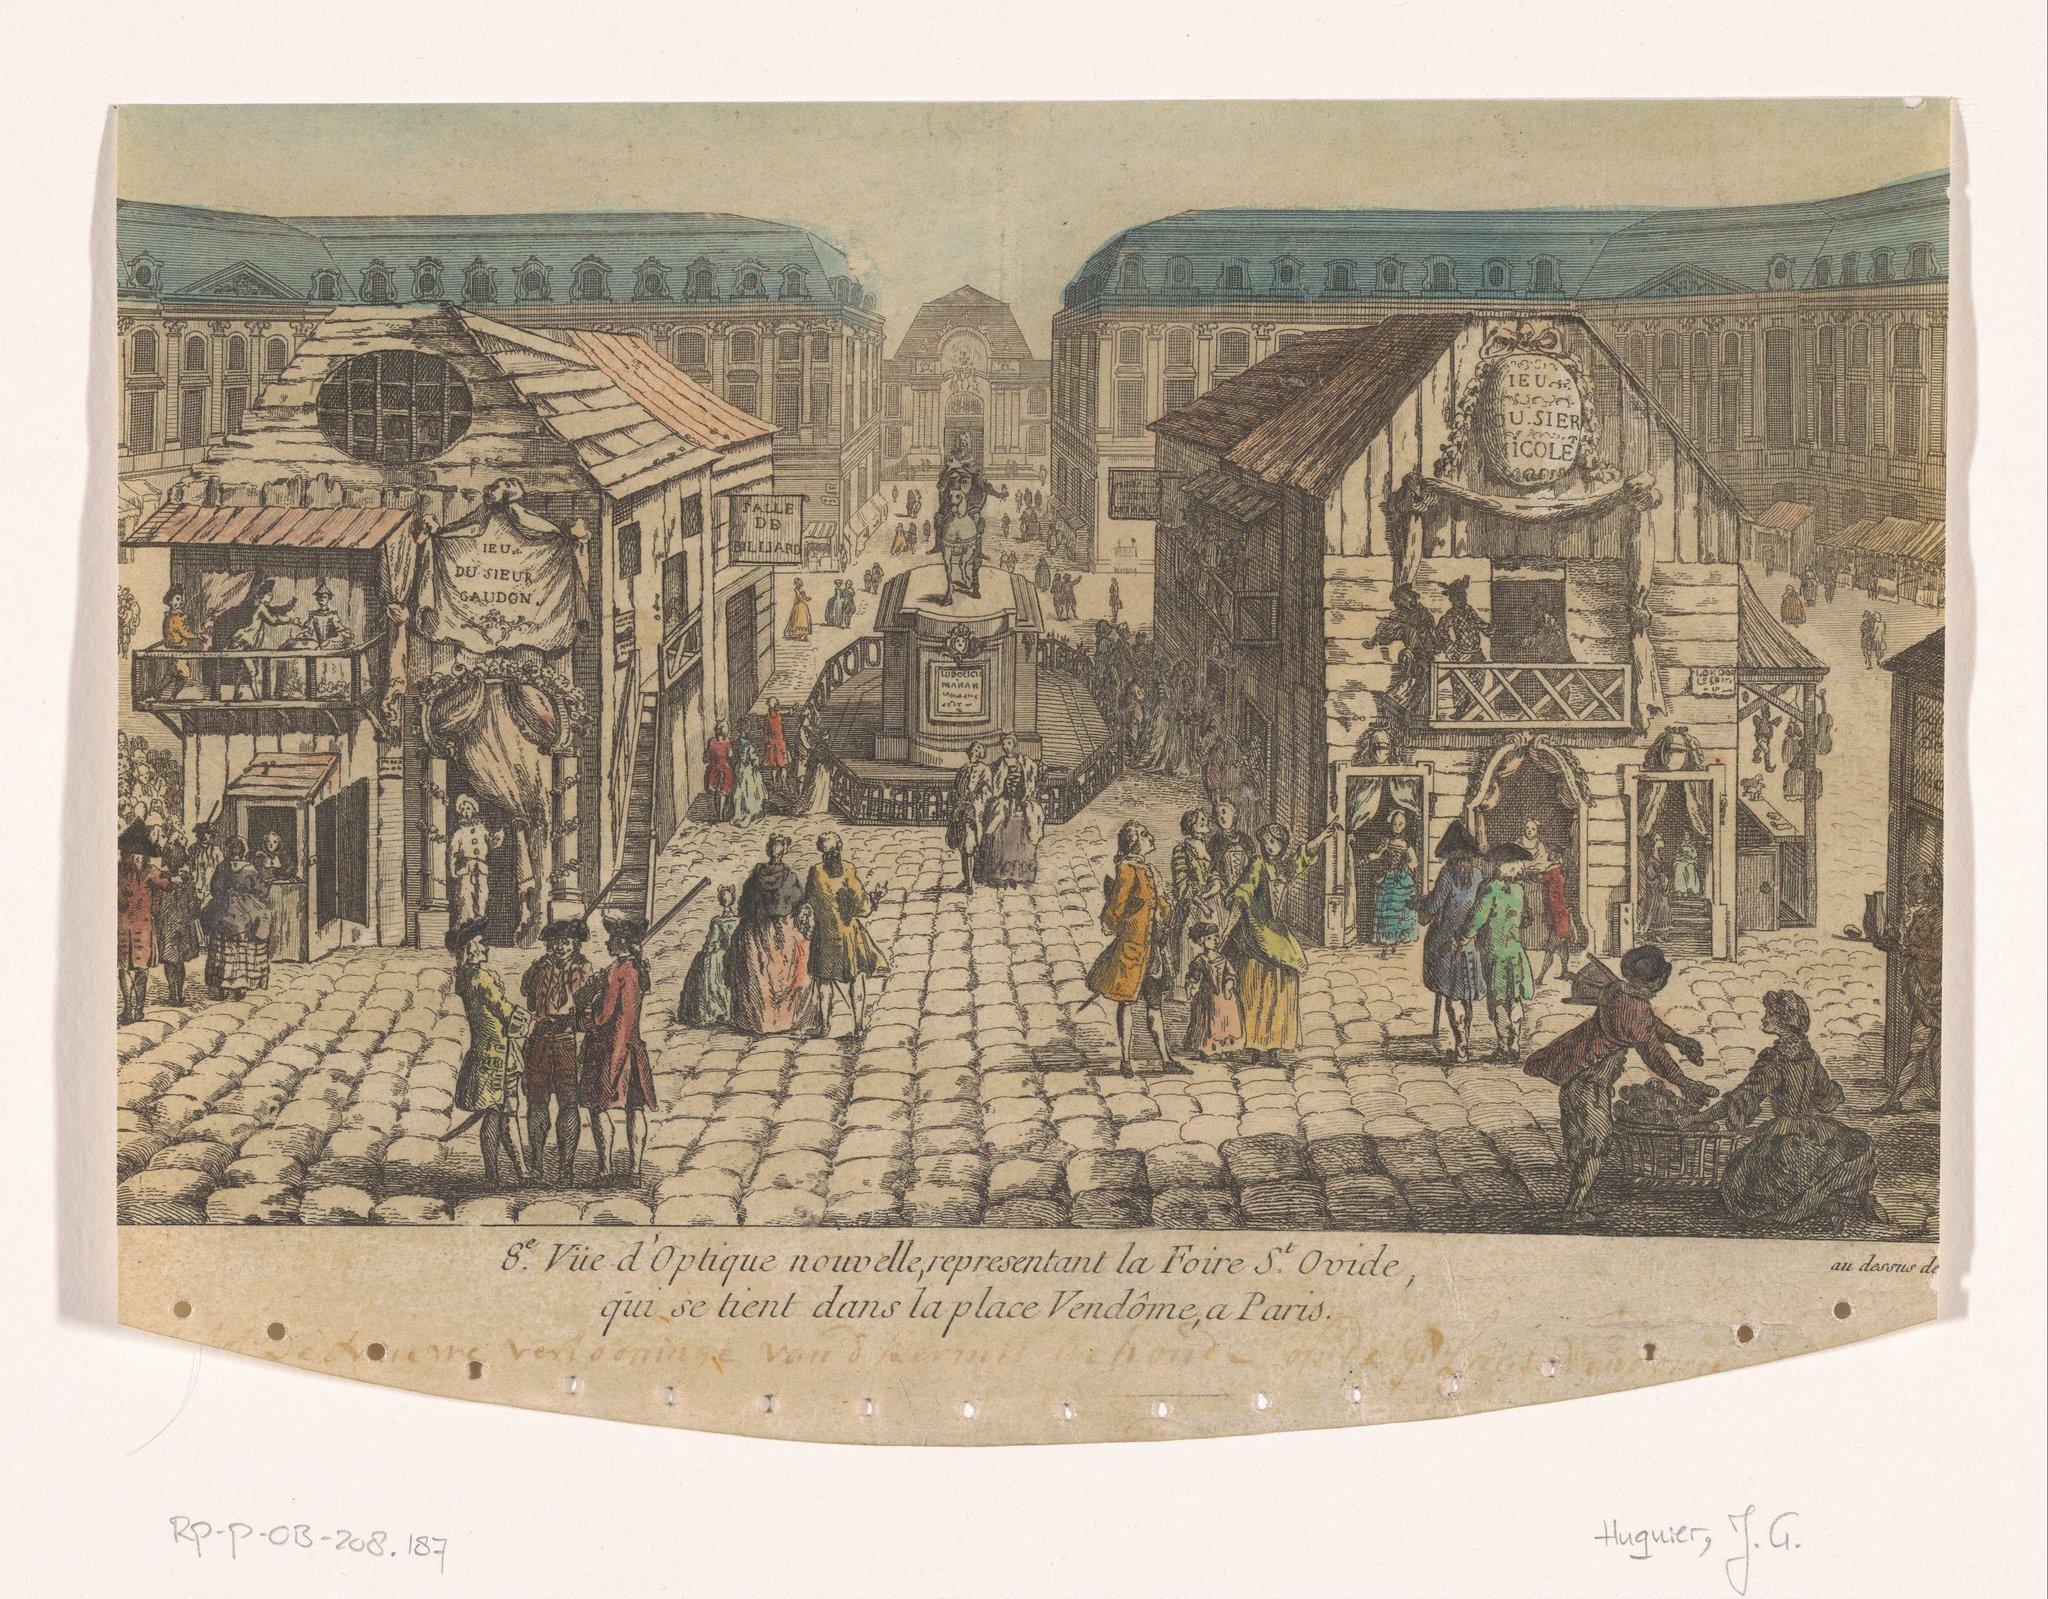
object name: print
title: Gezicht op de Place Vendôme te Parijs met de Saint-Ovide Kermis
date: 1735-1805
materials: paper, watercolor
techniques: brush, etching, perforating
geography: paris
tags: pleasure fair and circus, square, place, circus, etc. (+ city(-scape) with figures, staffage)